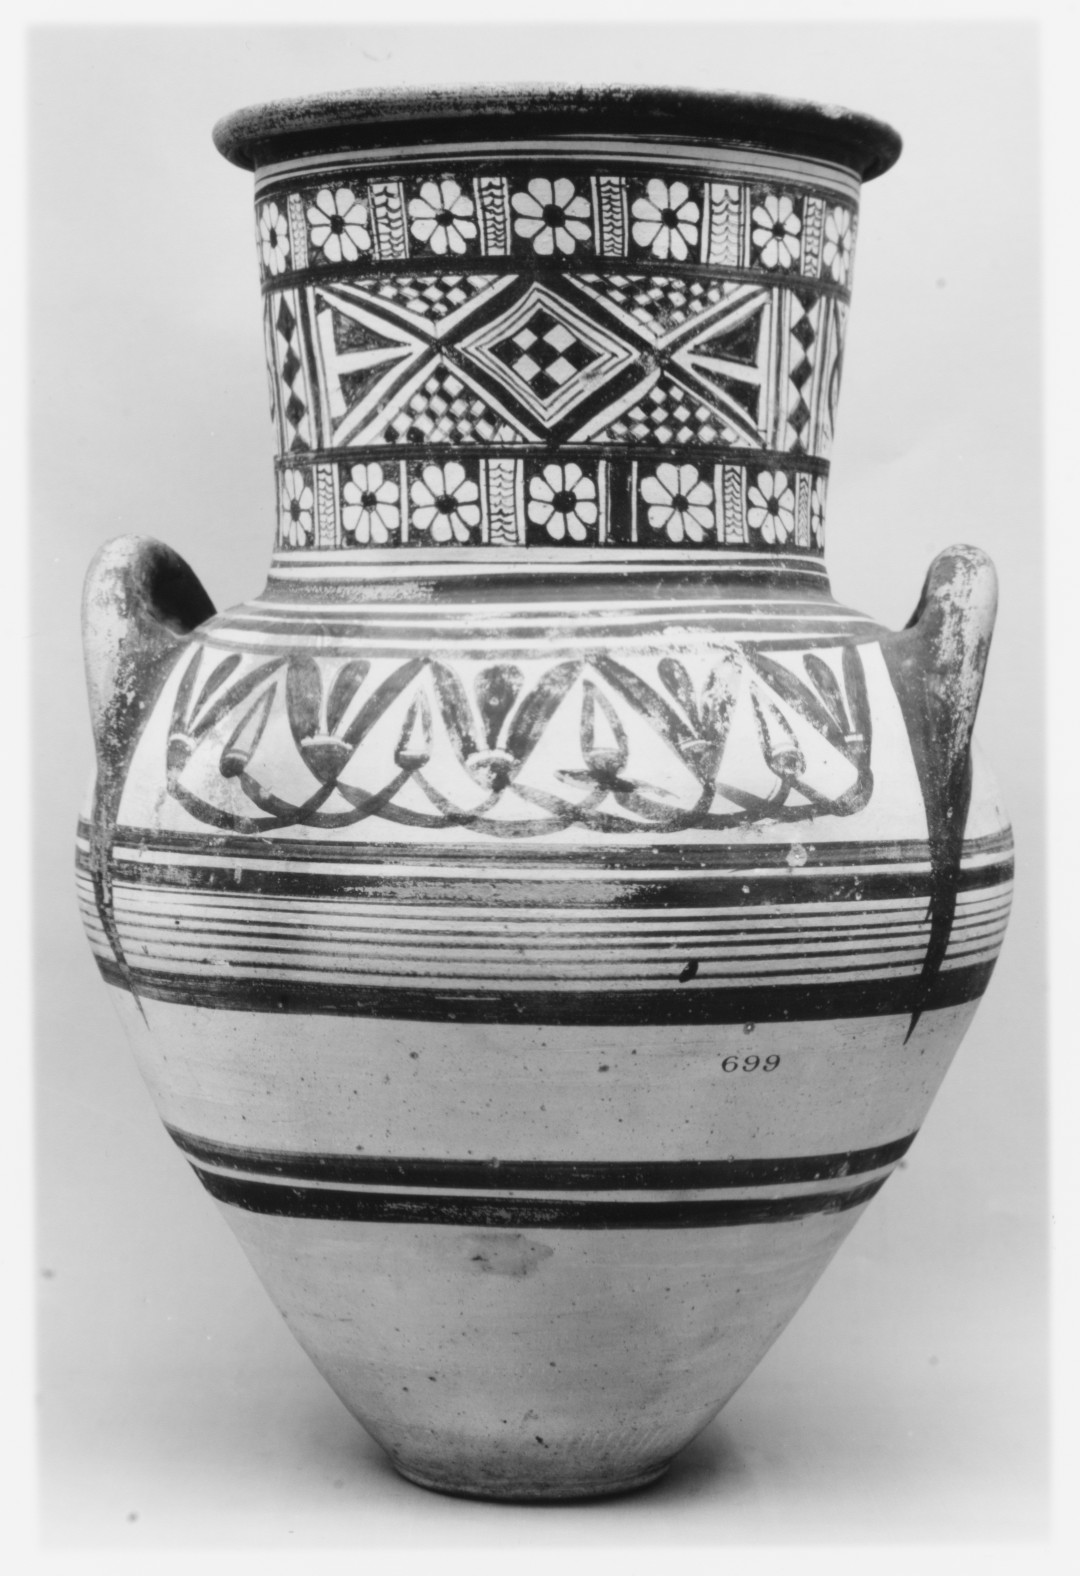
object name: amphora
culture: cypriot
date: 750-600 BCE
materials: terracotta